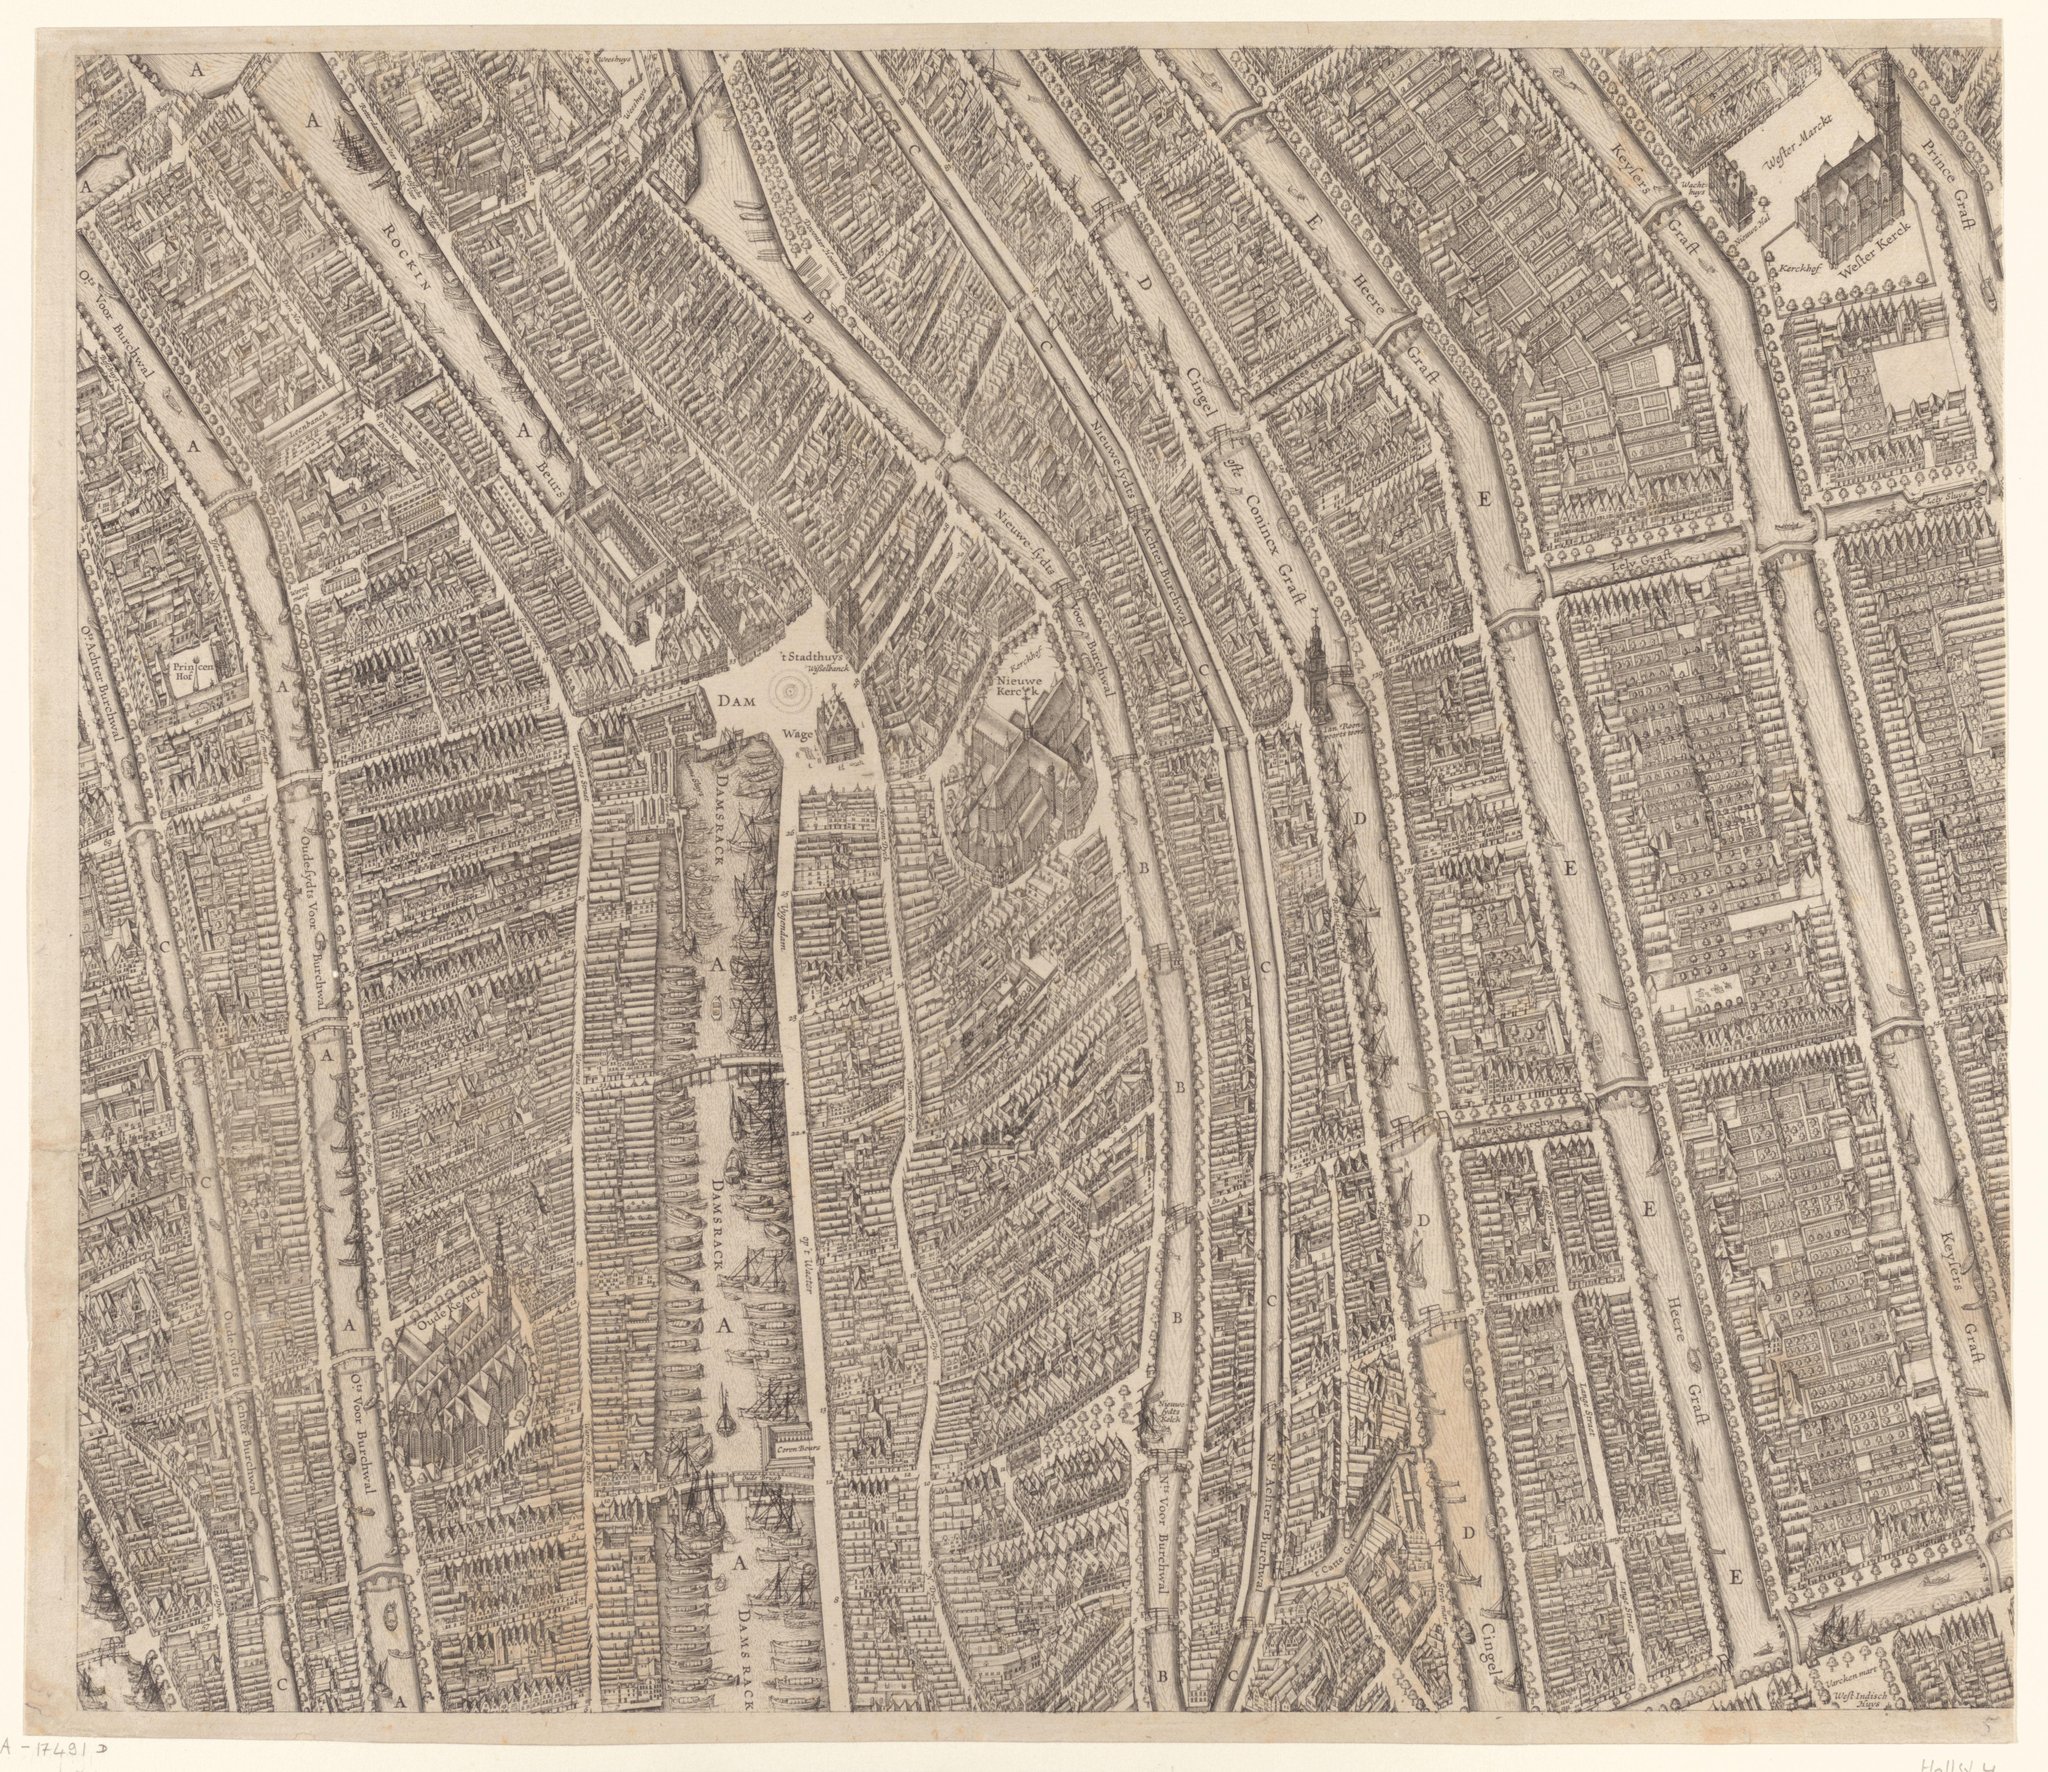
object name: print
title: Plattegrond van Amsterdam (blad midden)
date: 1625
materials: paper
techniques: etching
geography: northern netherlands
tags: maps of cities, amsterdam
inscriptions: collector's mark: Lugt 2228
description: Grote plattegrond van de stad Amsterdam uit 1625. Linksboven een gezicht op de stad en rechtsboven een kaart van de omgeving. Rechts een lijst met de namen van straten aan de Oude en de Nieuwe stadszijde. De plattegrond is samengesteld uit negen platen, waarvan twee ontbreken. Dit is het middenblad met de Dam, de Oudekerk en de Nieuwekerk.